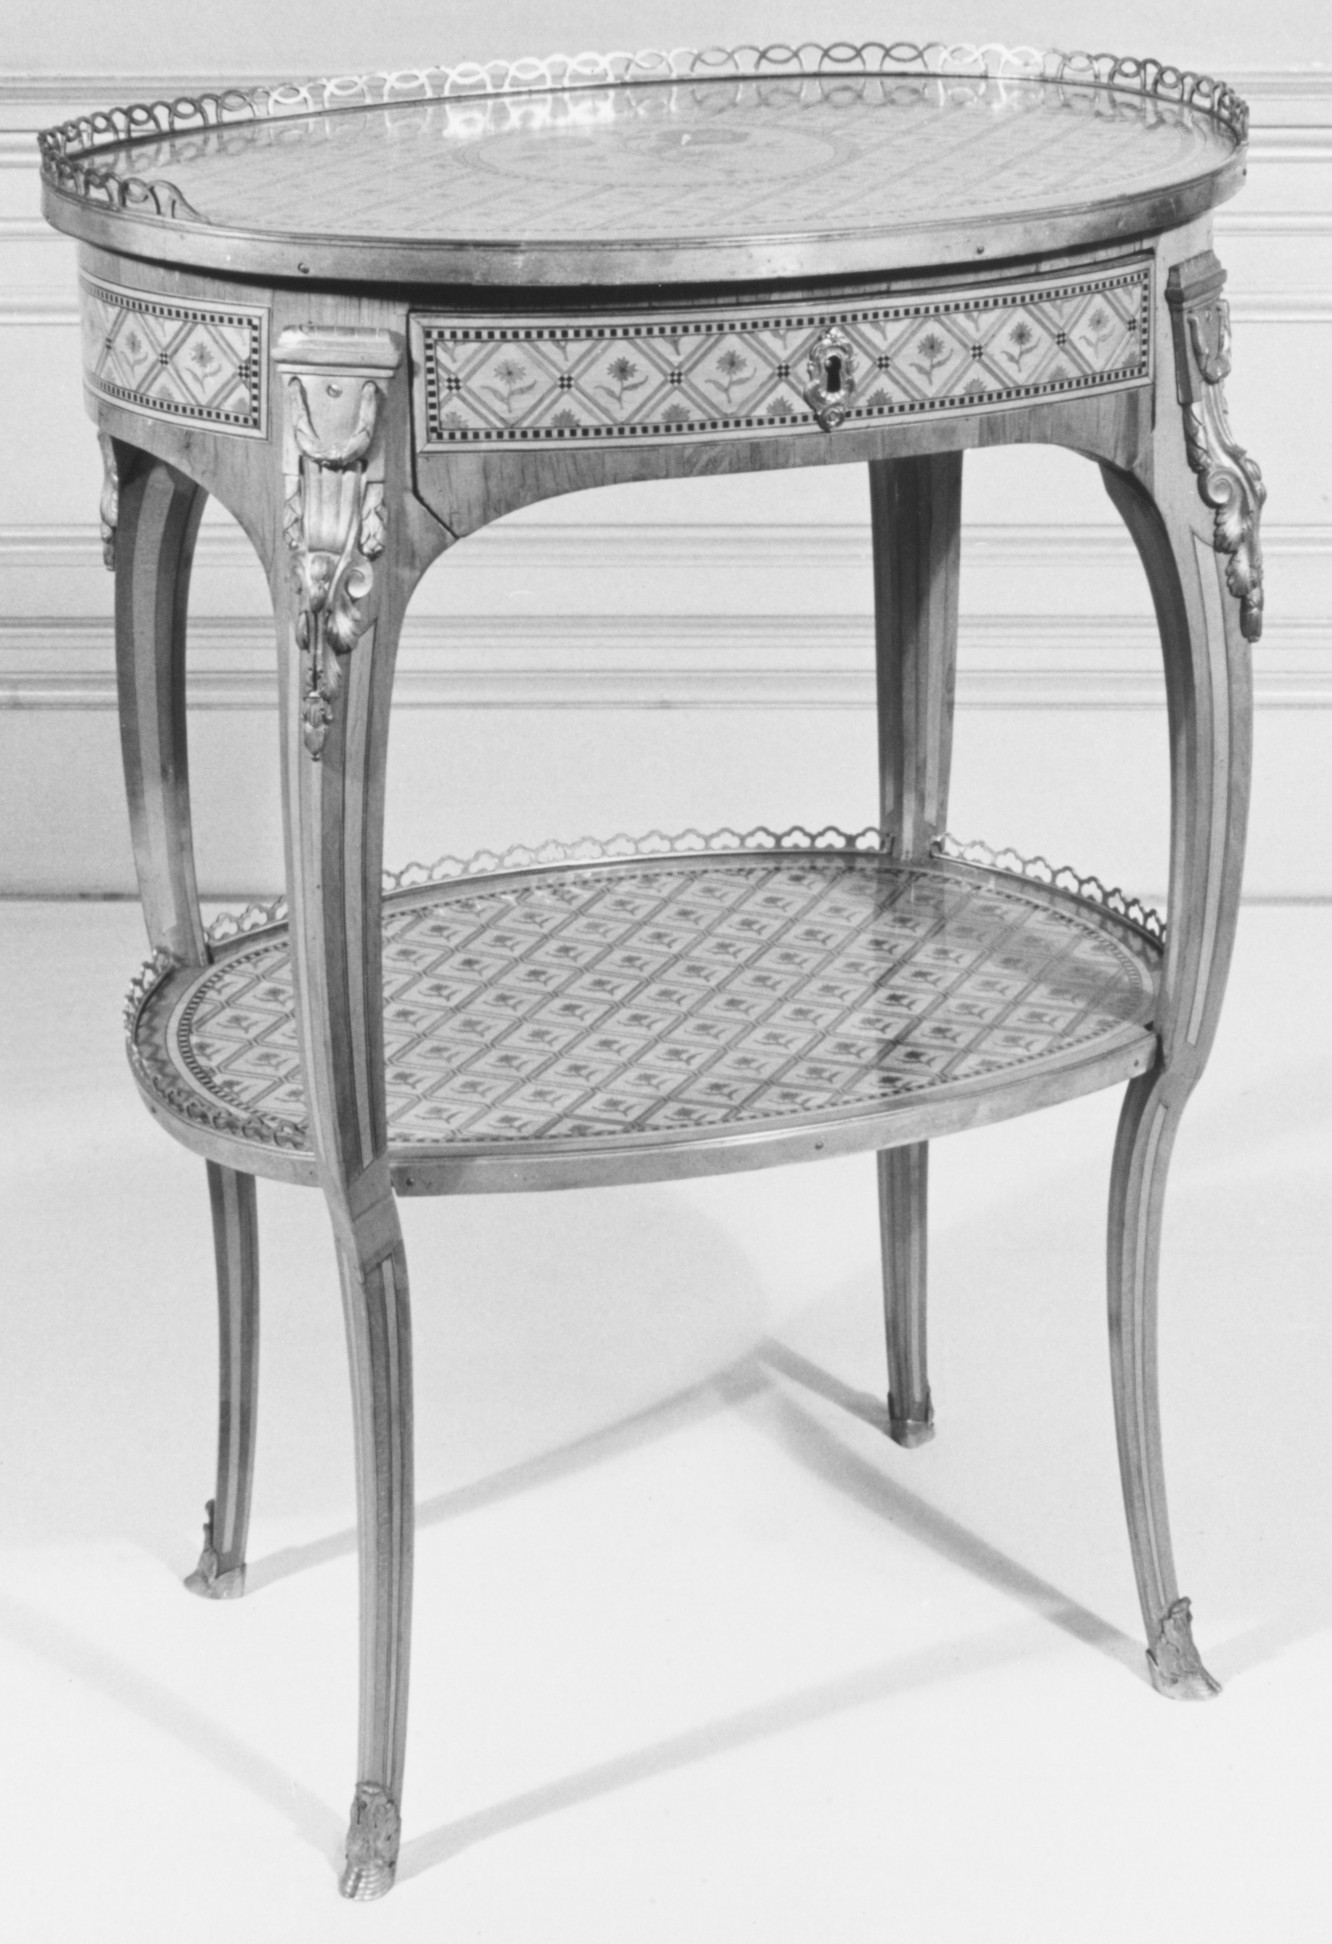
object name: table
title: Oval table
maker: roger vandercruse, called lacroix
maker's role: maker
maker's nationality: french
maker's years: 1727-1799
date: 1770-1775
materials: gilt bronze, leather, wood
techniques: stain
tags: flowers